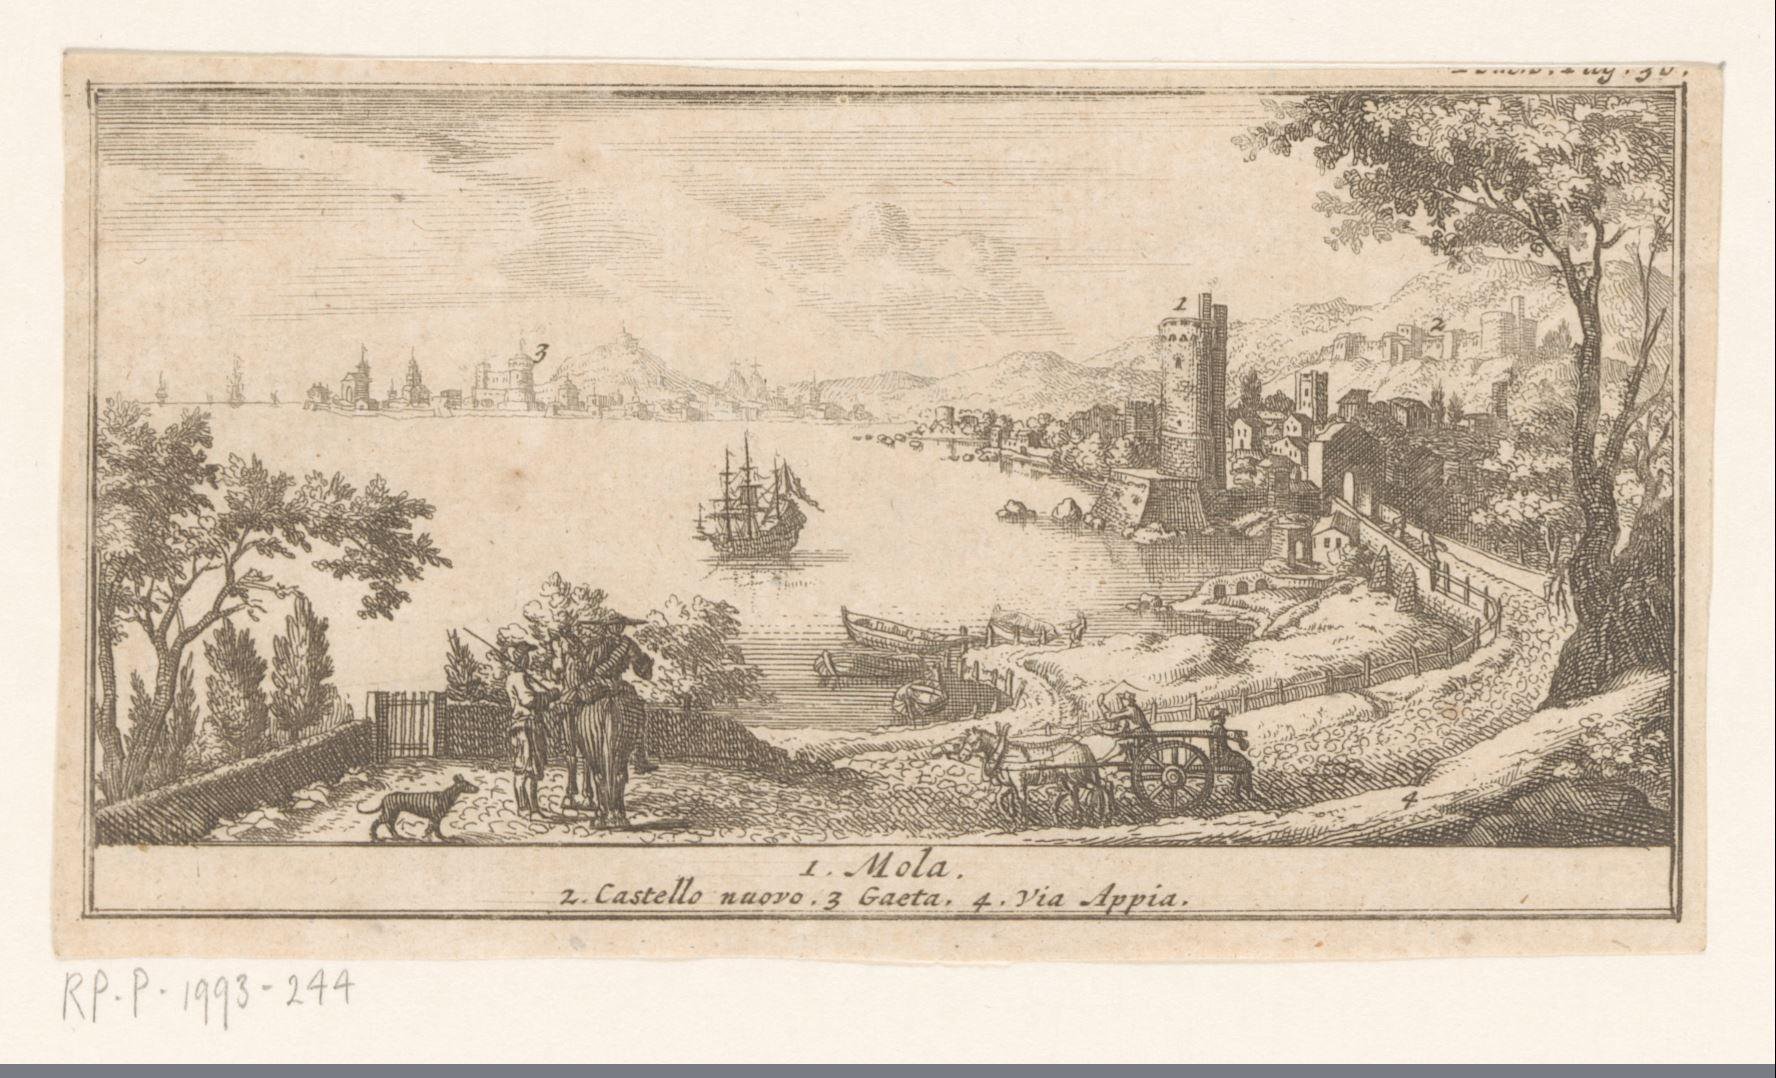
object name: print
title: Golf van Gaeta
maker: pieter van der aa (i)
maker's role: printer, publisher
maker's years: 1659-1733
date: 1682-1730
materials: paper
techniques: etching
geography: leiden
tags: gulf, bay, sailing-ship, sailing-boat, landscapes, castle, coast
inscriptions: collector's mark: Lugt 2228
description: Gezicht op de Golf van Gaeta aan de Italiaanse westkust. Op het water vaart een zeilschip. Op de achtergrond rechts een toren en een kasteel. Op de voorgrond loopt een weg. Lijst met verklarende letters in ondermarge.